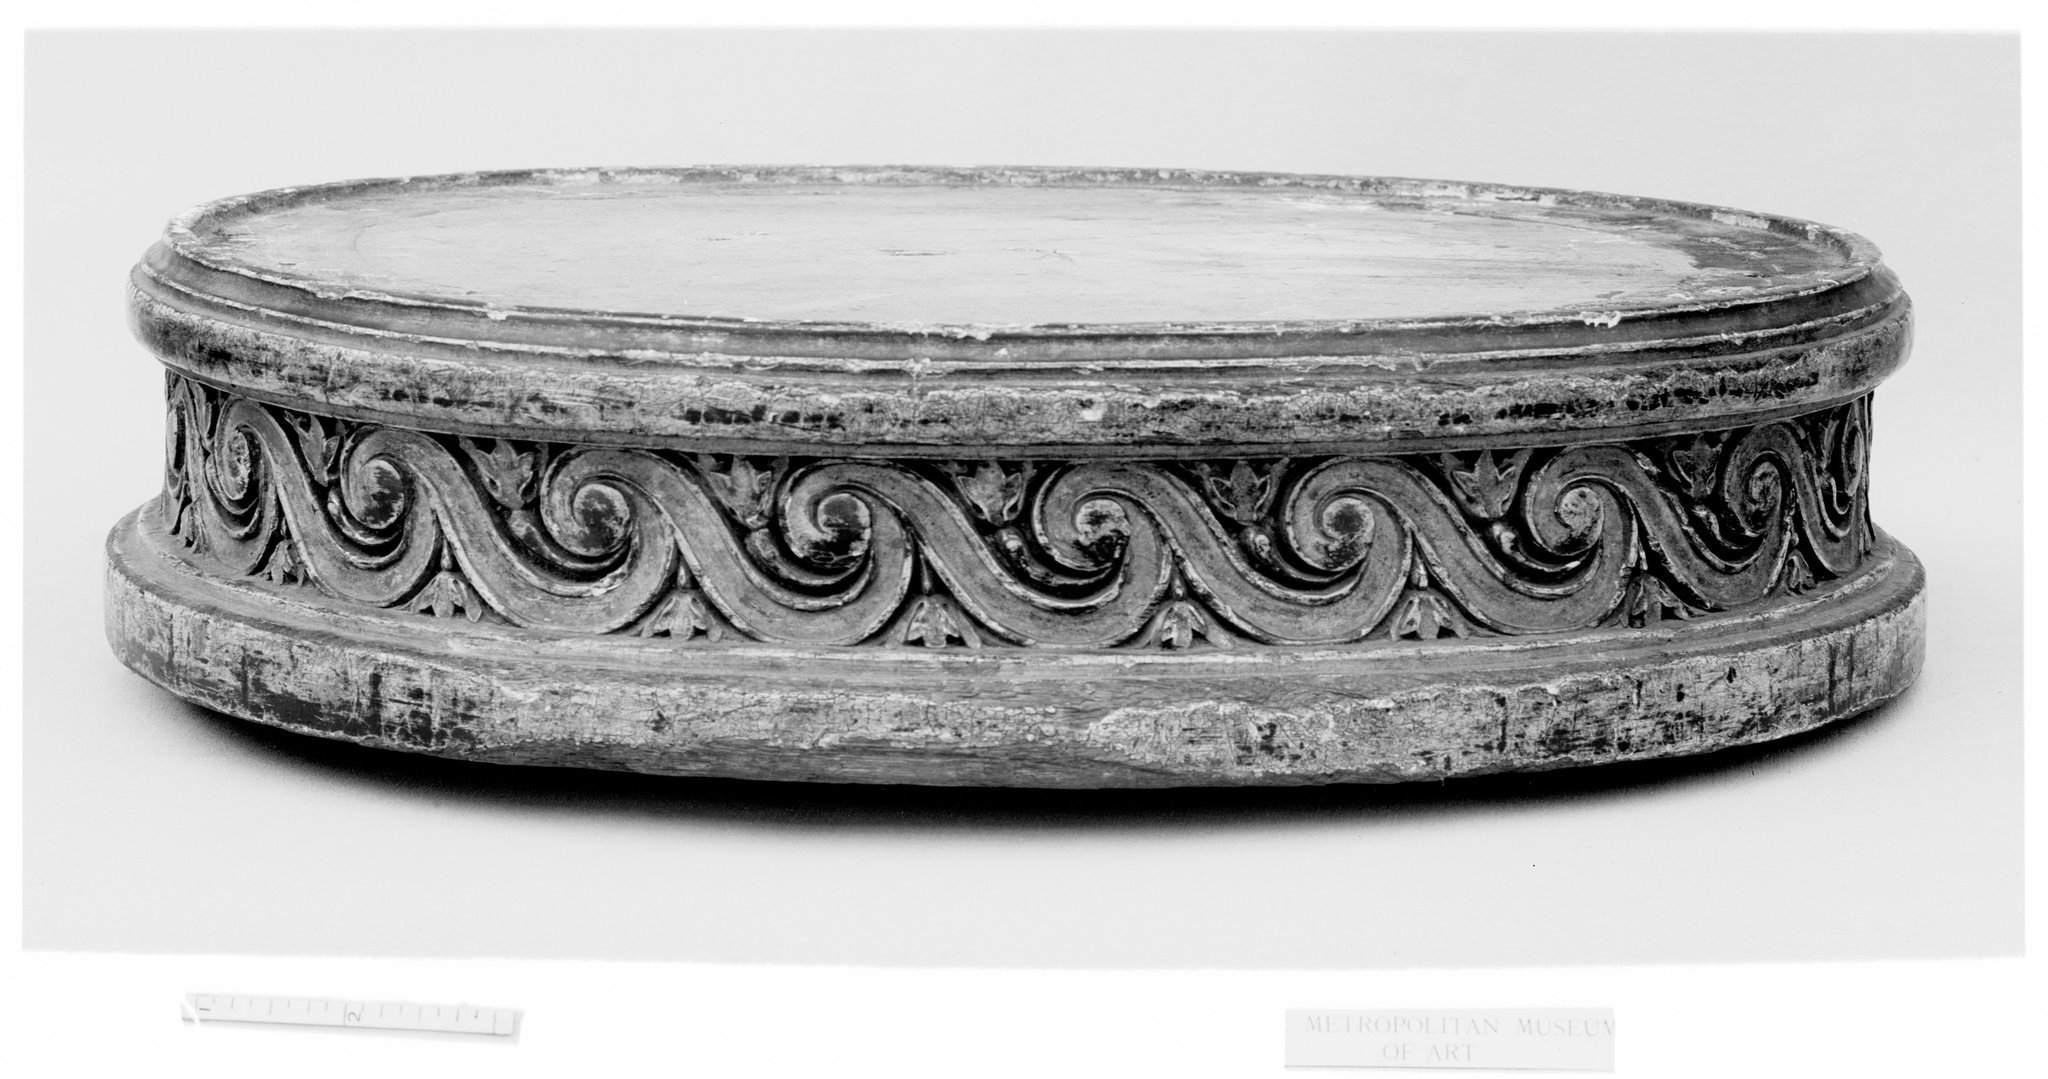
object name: plinth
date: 1701-1800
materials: gilt, wood